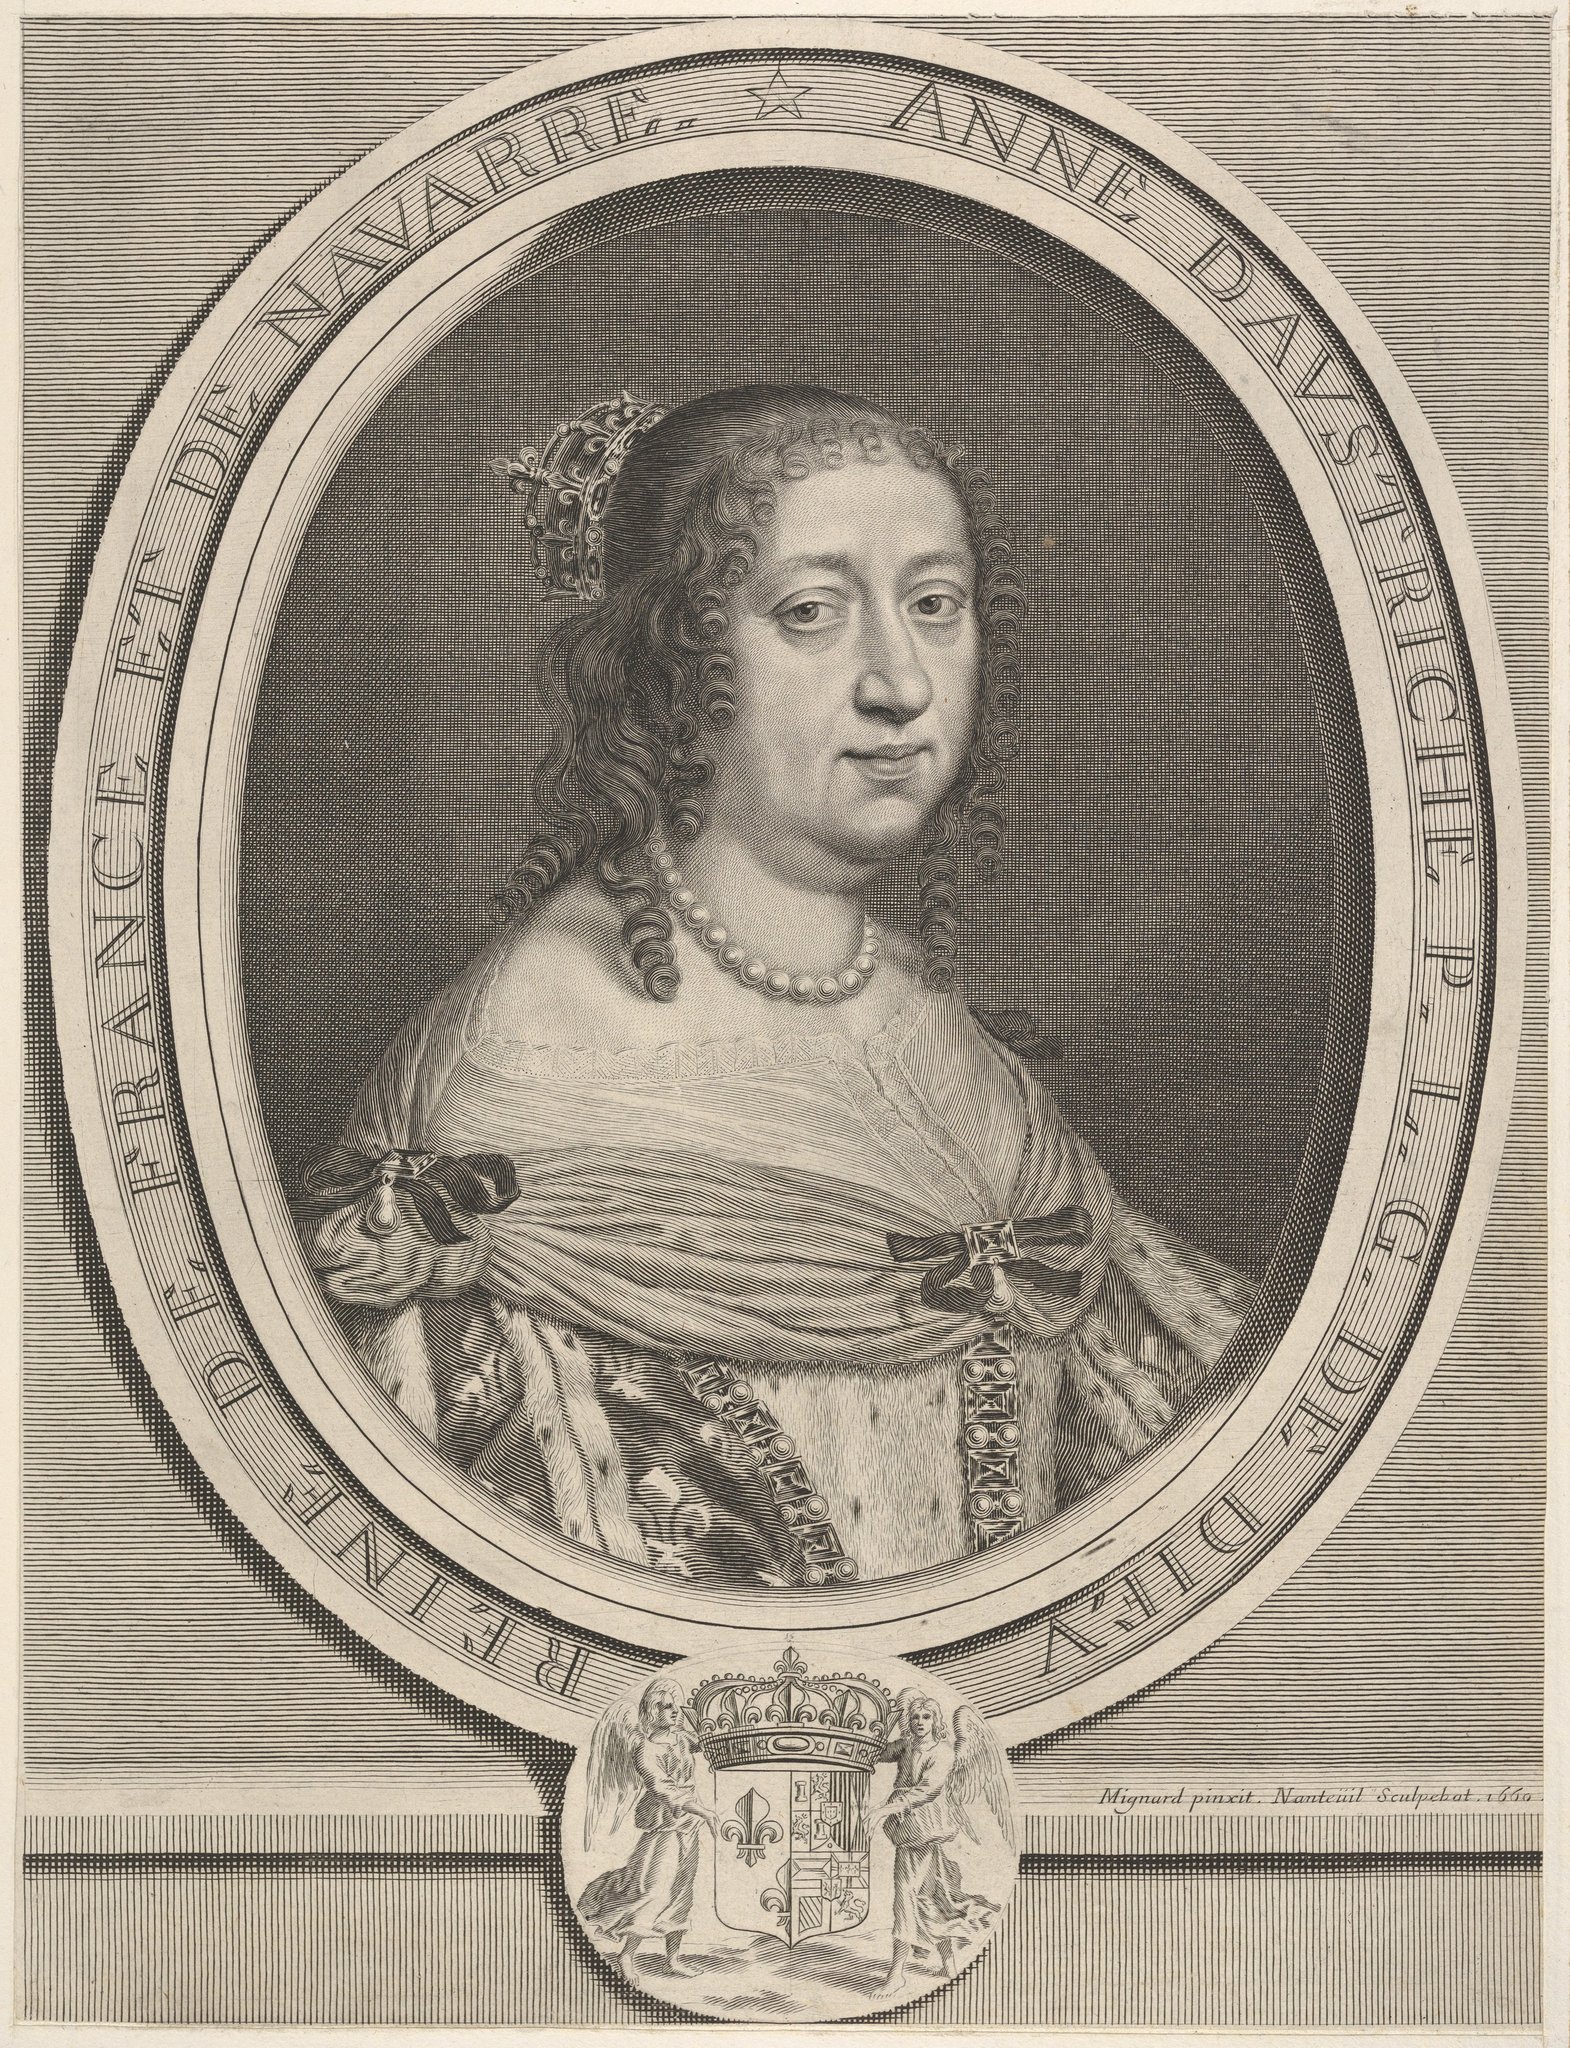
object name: print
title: Anne of Austria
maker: robert nanteuil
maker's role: artist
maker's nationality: french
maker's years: 1623-1678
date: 1660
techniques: engraving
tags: portraits,women,coat of arms